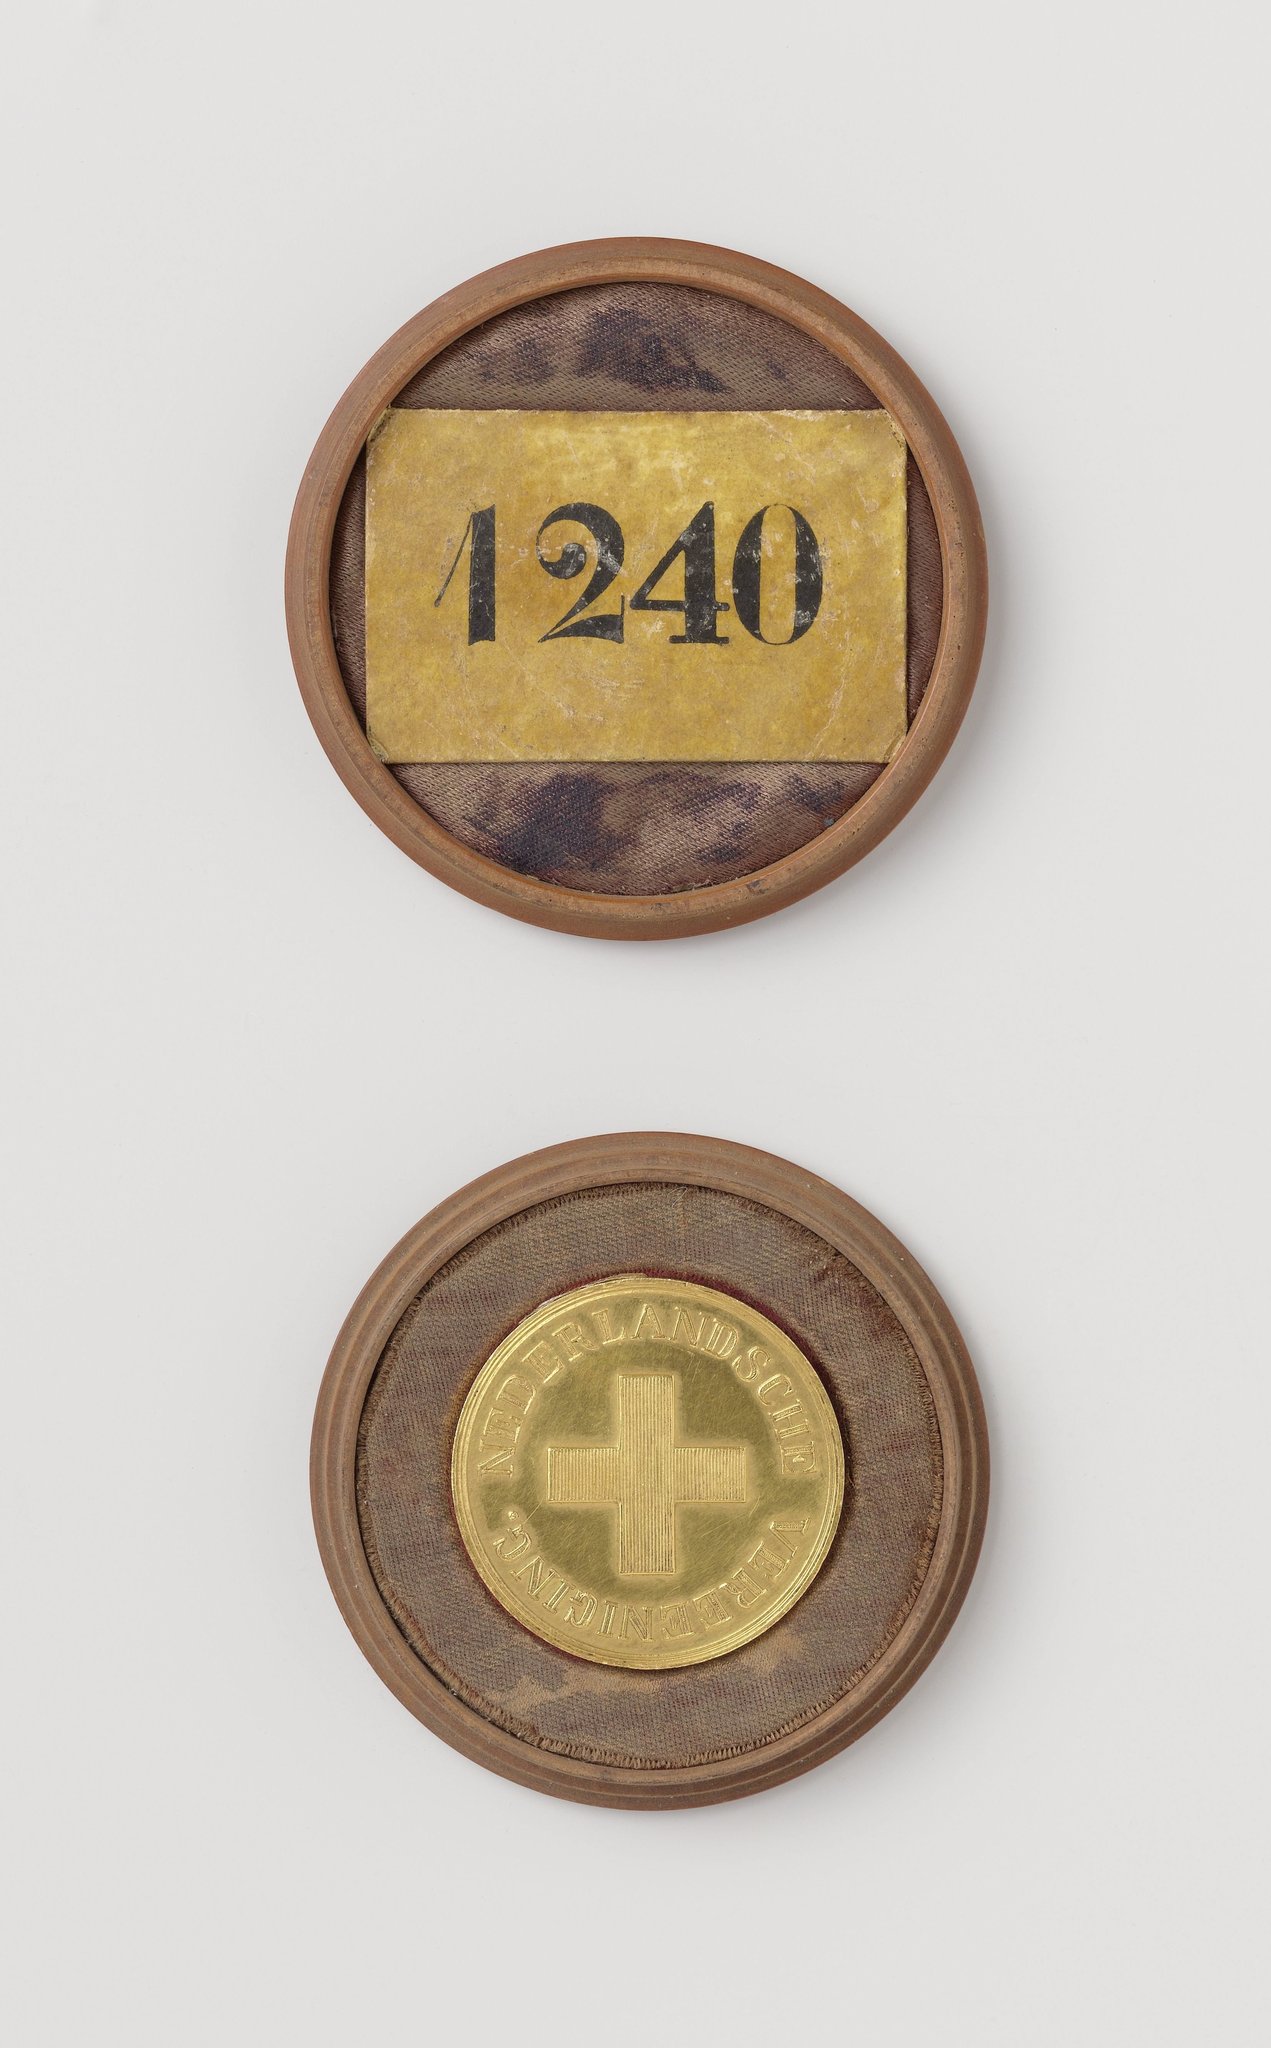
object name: medal box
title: Box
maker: Anonymous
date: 1869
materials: wood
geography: netherlands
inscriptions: label, on the inside of the lid: ‘1240’ former inventory label